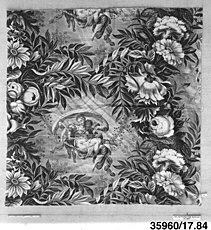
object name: fragment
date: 1801-1900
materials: cotton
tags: women,flowers